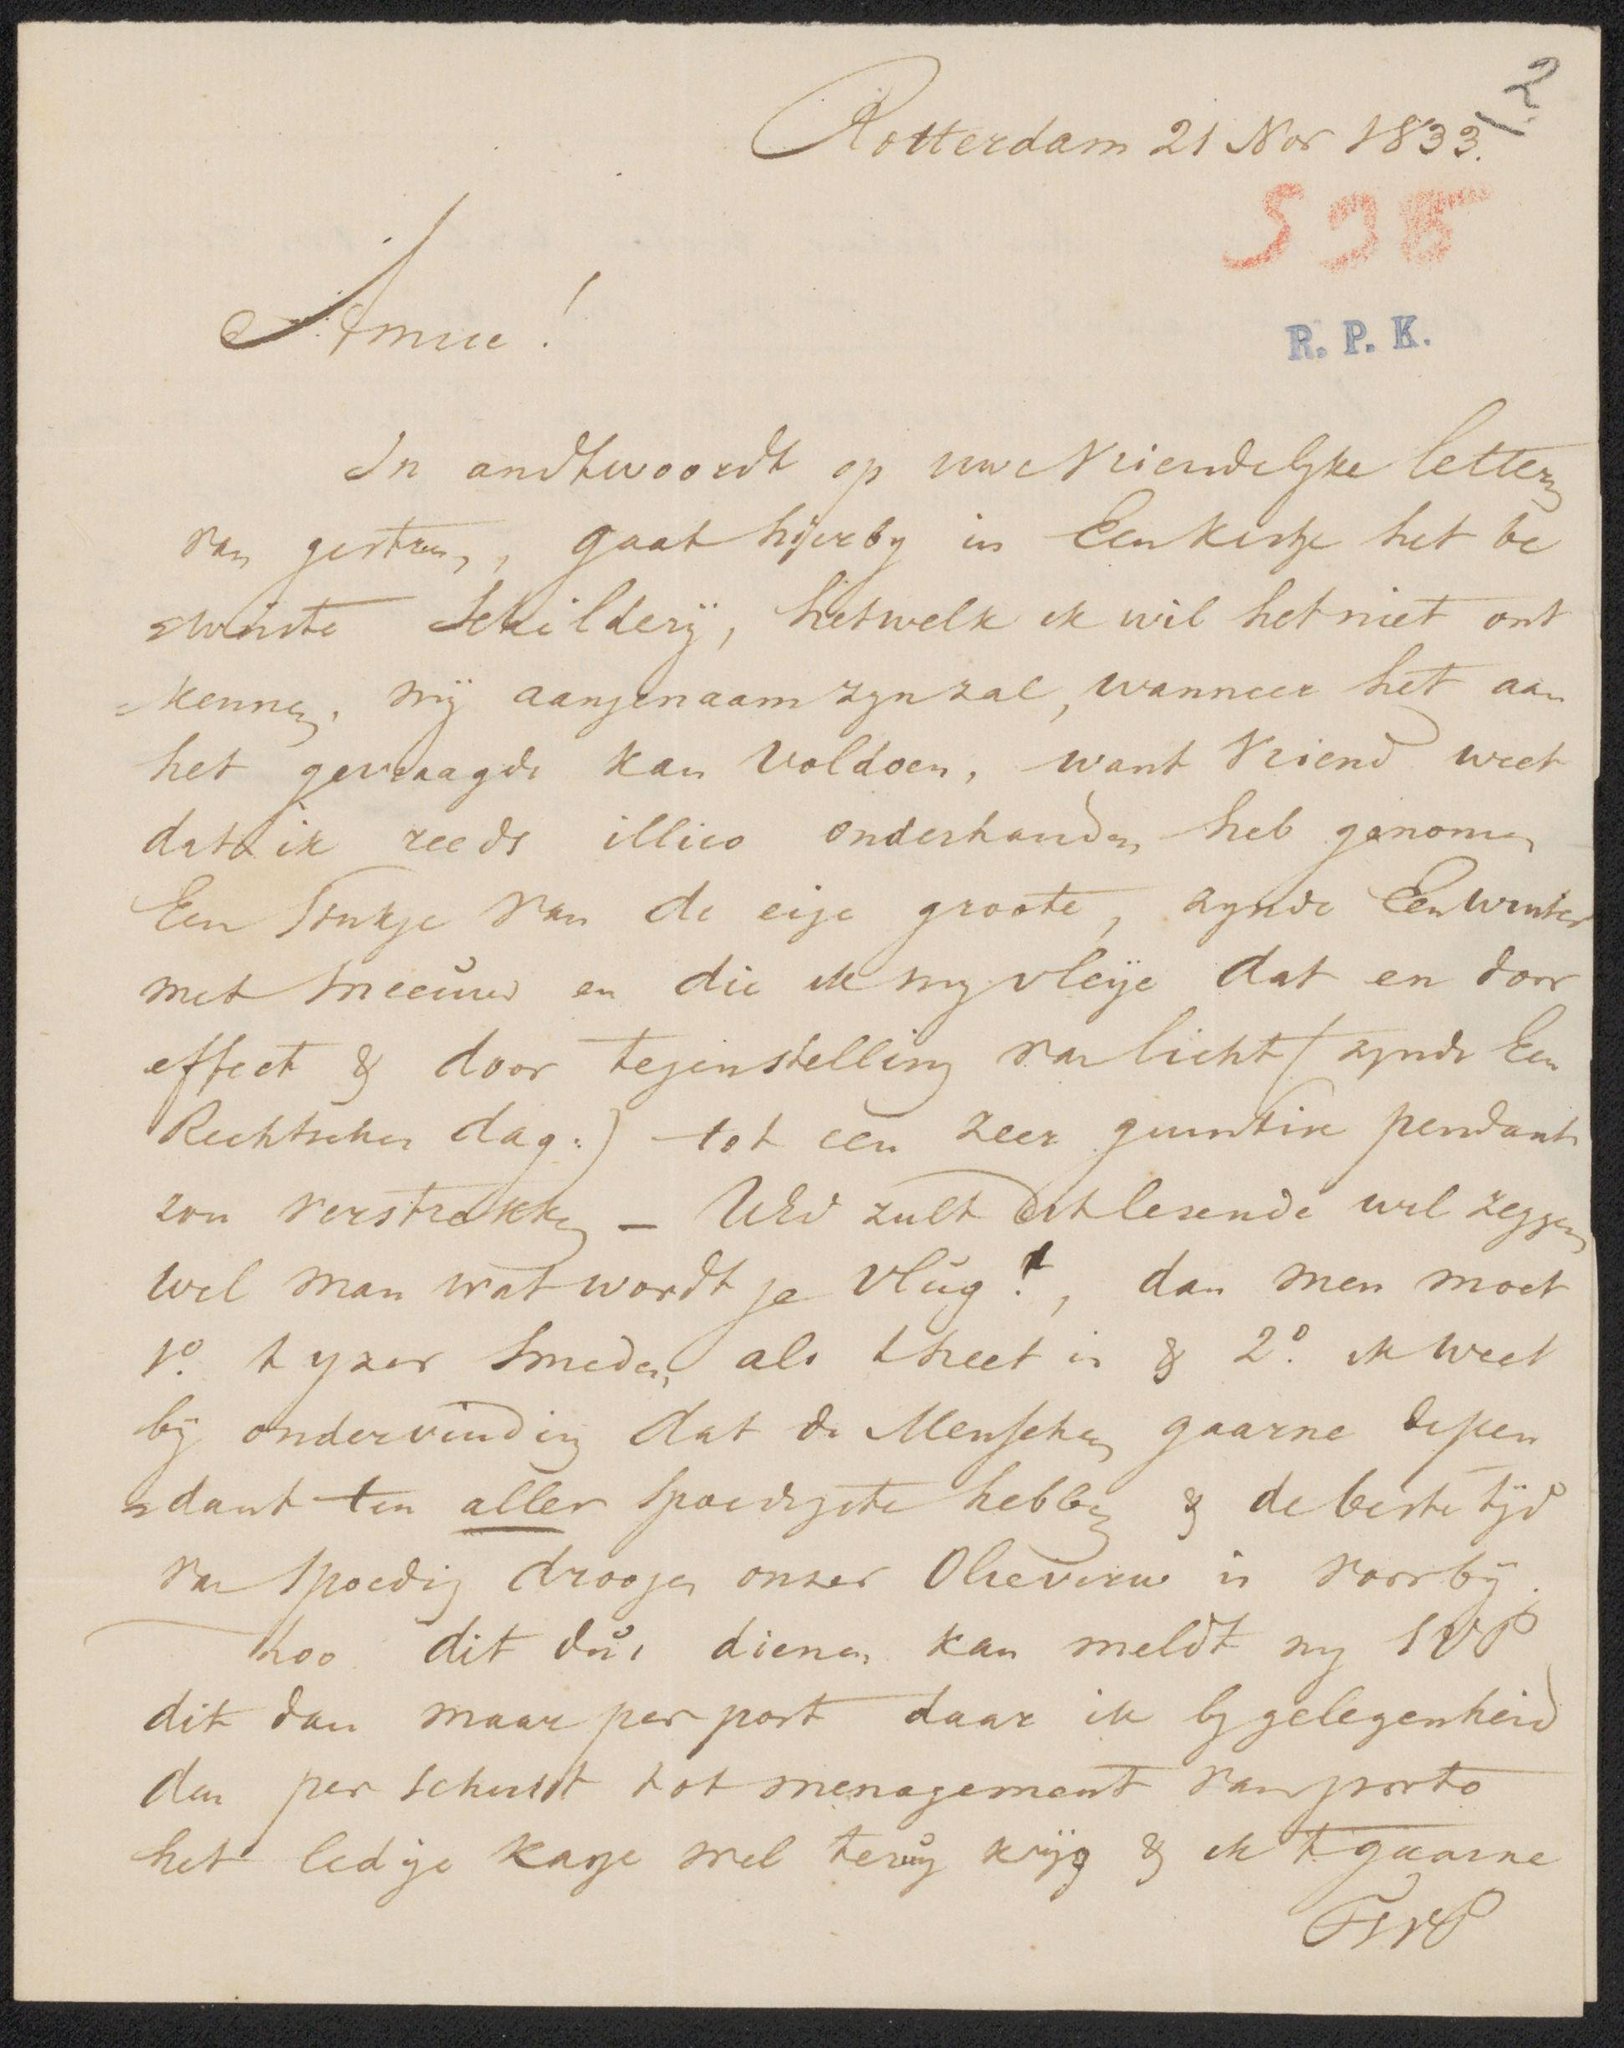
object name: letter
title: Brief aan Christiaan Kramm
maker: cornelis gerrit verburgh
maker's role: print maker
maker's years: 1802-1879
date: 1833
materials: ink, paper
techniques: pen, writing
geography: rotterdam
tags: utrecht, print maker, draughtsman, christiaan kramm, painting (including book-illumination, miniature-painting)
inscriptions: collector's mark: Lugt 2233, seal, watermark